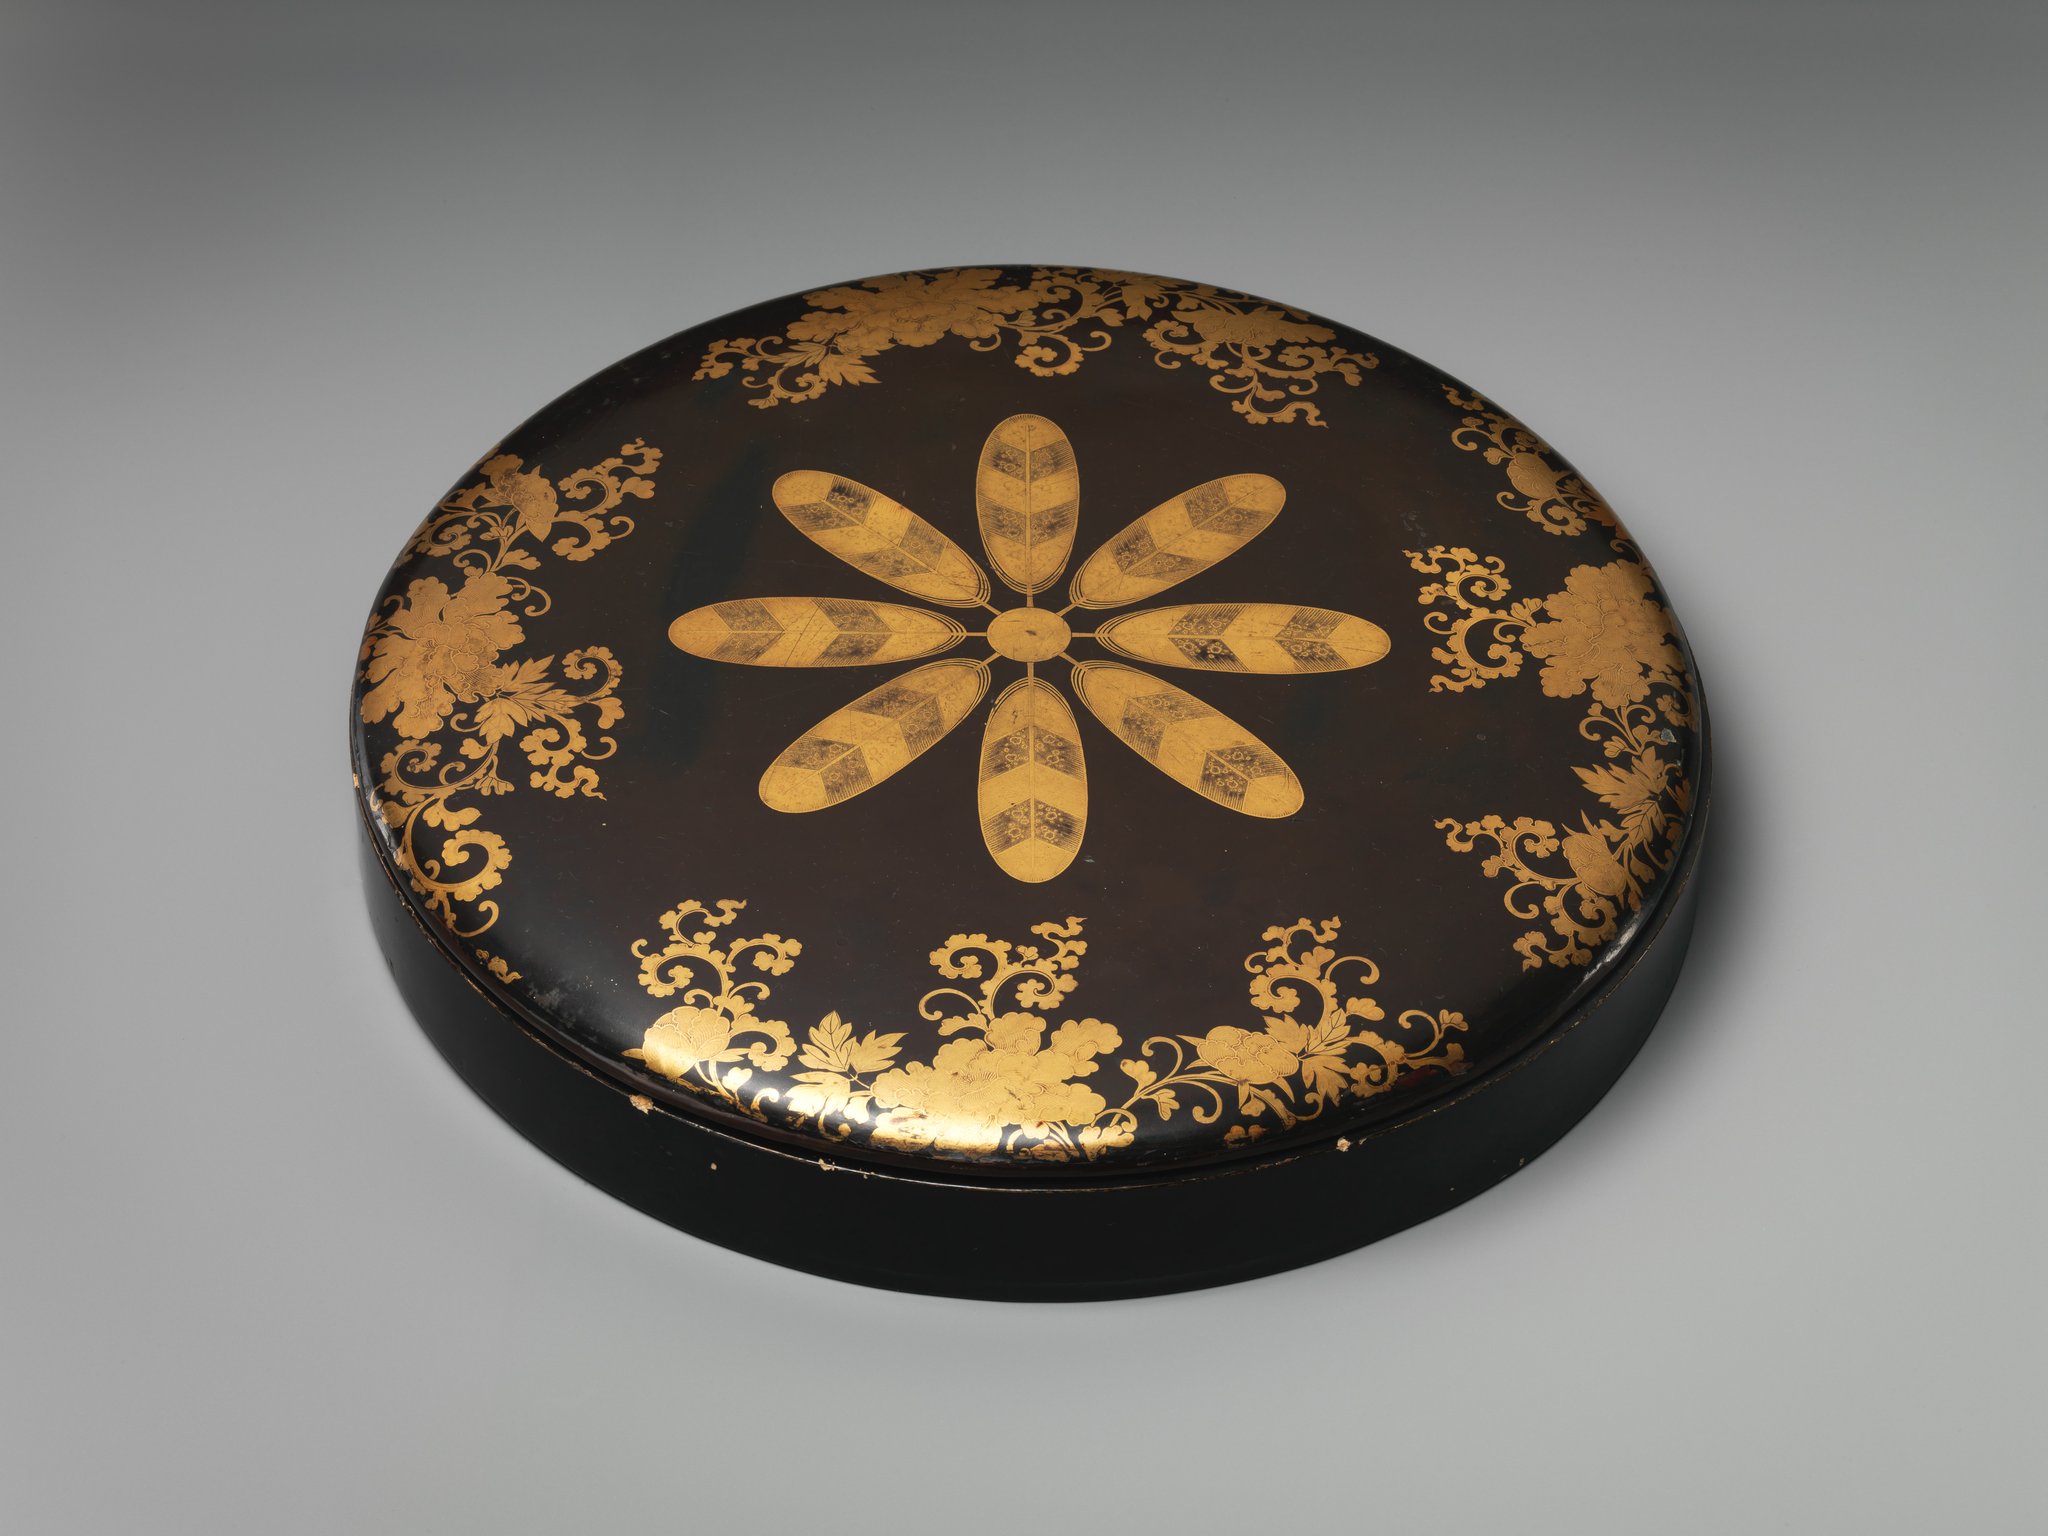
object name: covered box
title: Mirror, and Mirror Box (Kagami-bako) with Feather Crest and Peony Scrolls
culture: japanese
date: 1185-1799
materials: bronze, gold, lacquer, wood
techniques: hiramakie, lacquer